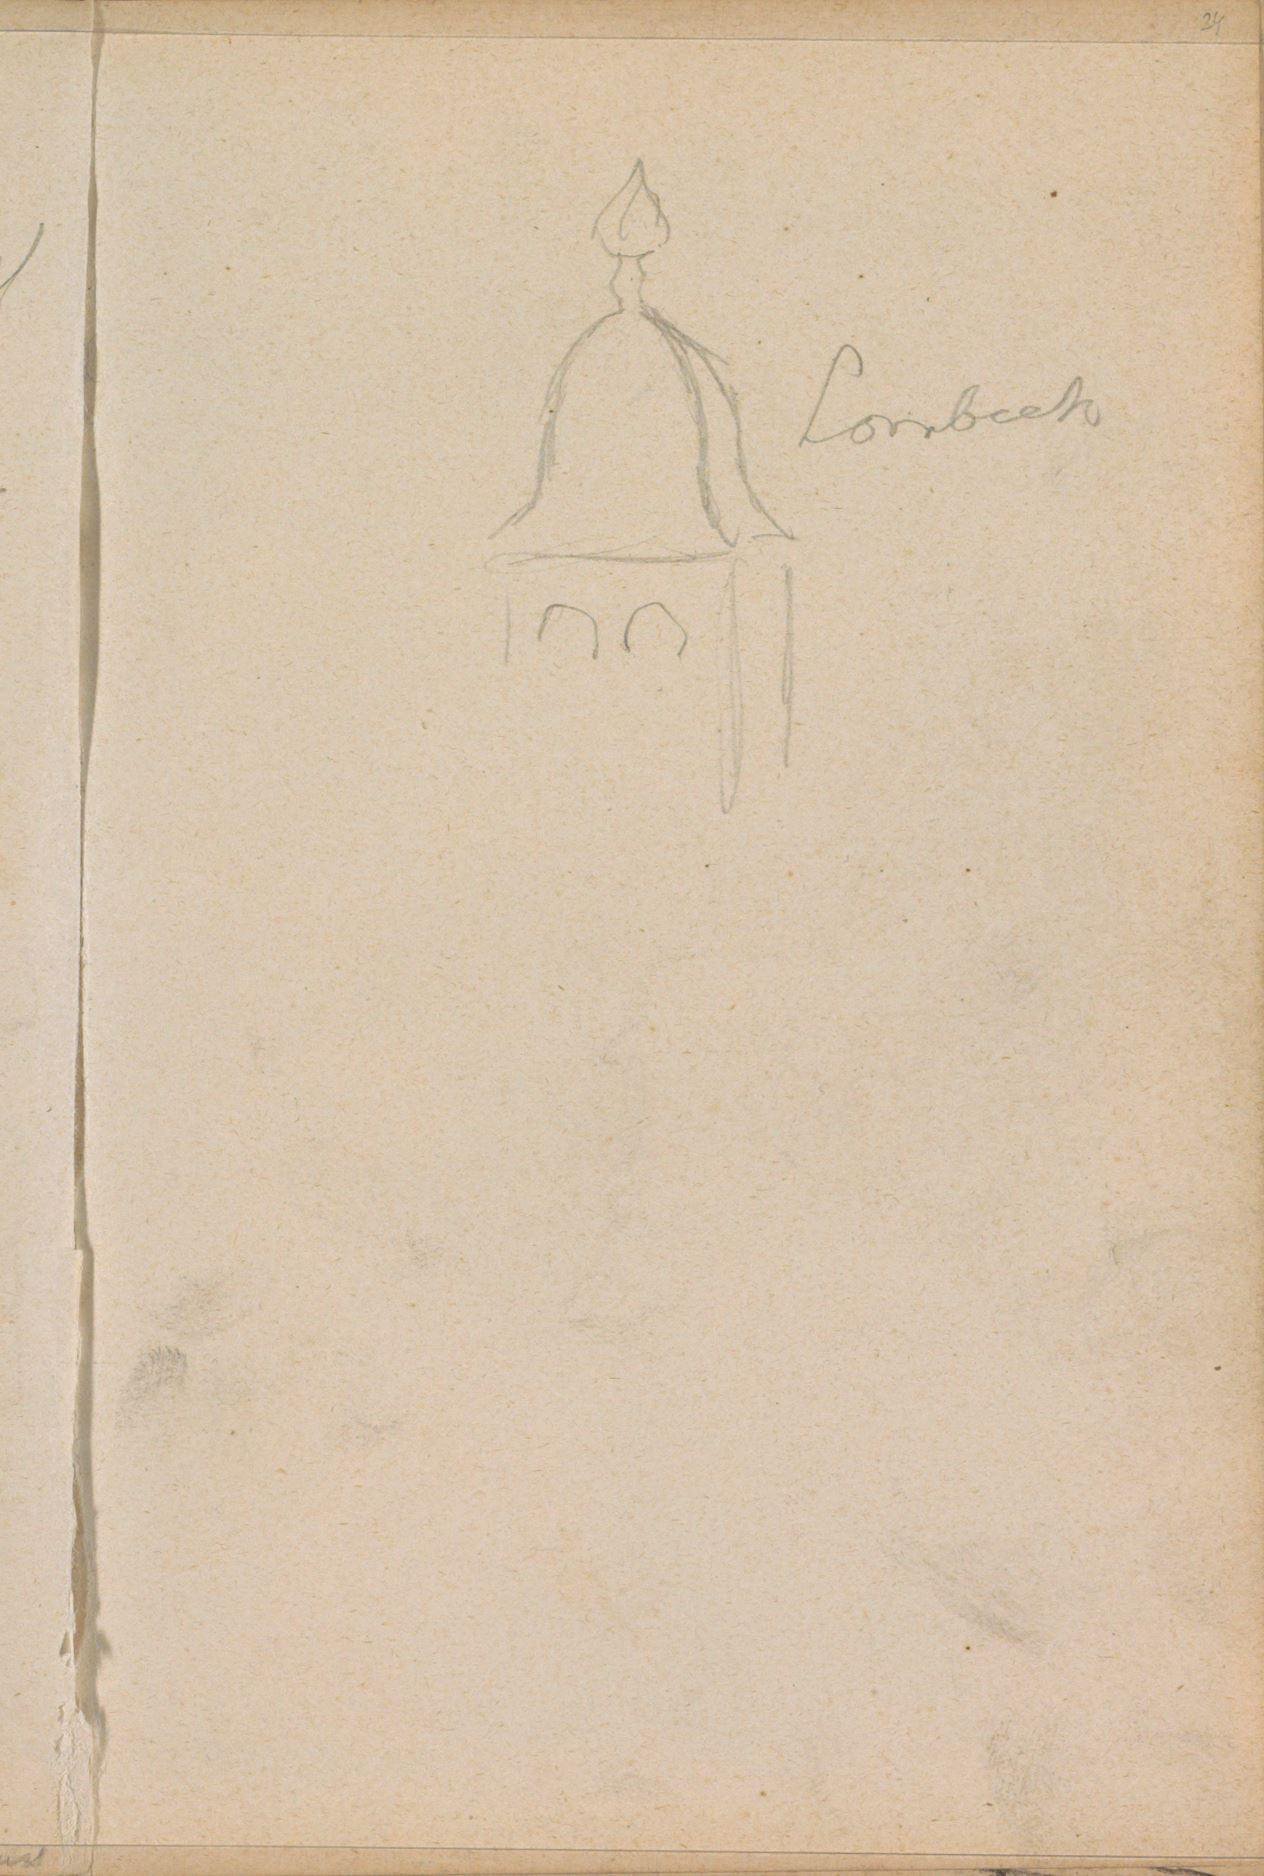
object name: sketchbook leaf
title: Toren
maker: george hendrik breitner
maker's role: draughtsman, painter, print maker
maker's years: 1857-1923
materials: paper, pencil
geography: belgium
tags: tower (of house or building)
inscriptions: annotation: ‘Loorbeek[?]’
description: Pagina 24 uit een schetsboek met 46 bladen.